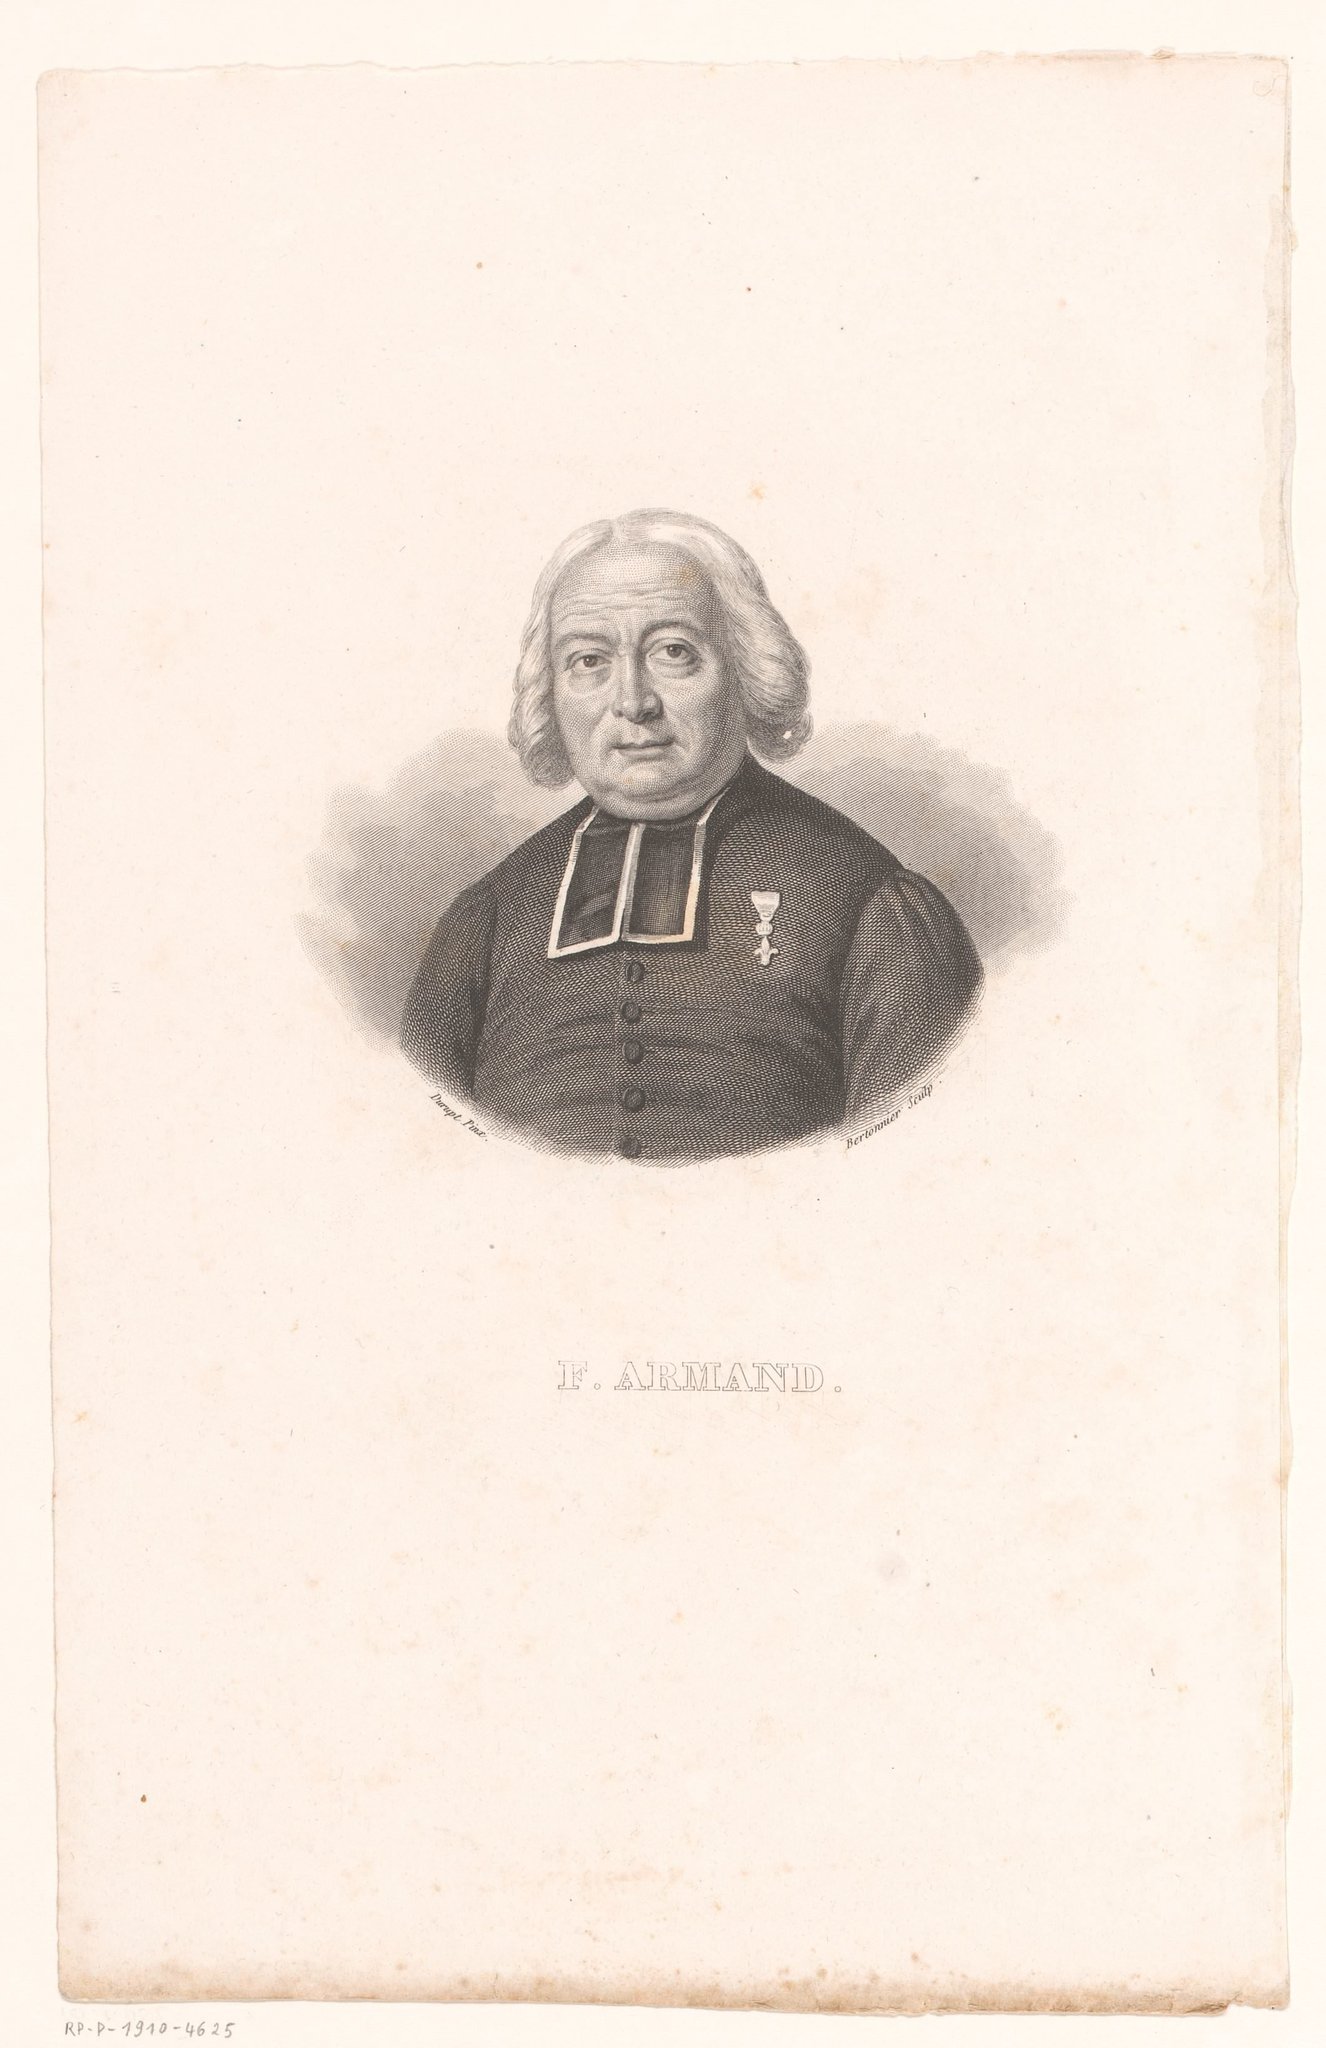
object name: print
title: Portret van F. Armand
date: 1801-1847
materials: paper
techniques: etching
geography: france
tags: historical persons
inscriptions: collector's mark: Lugt 2228